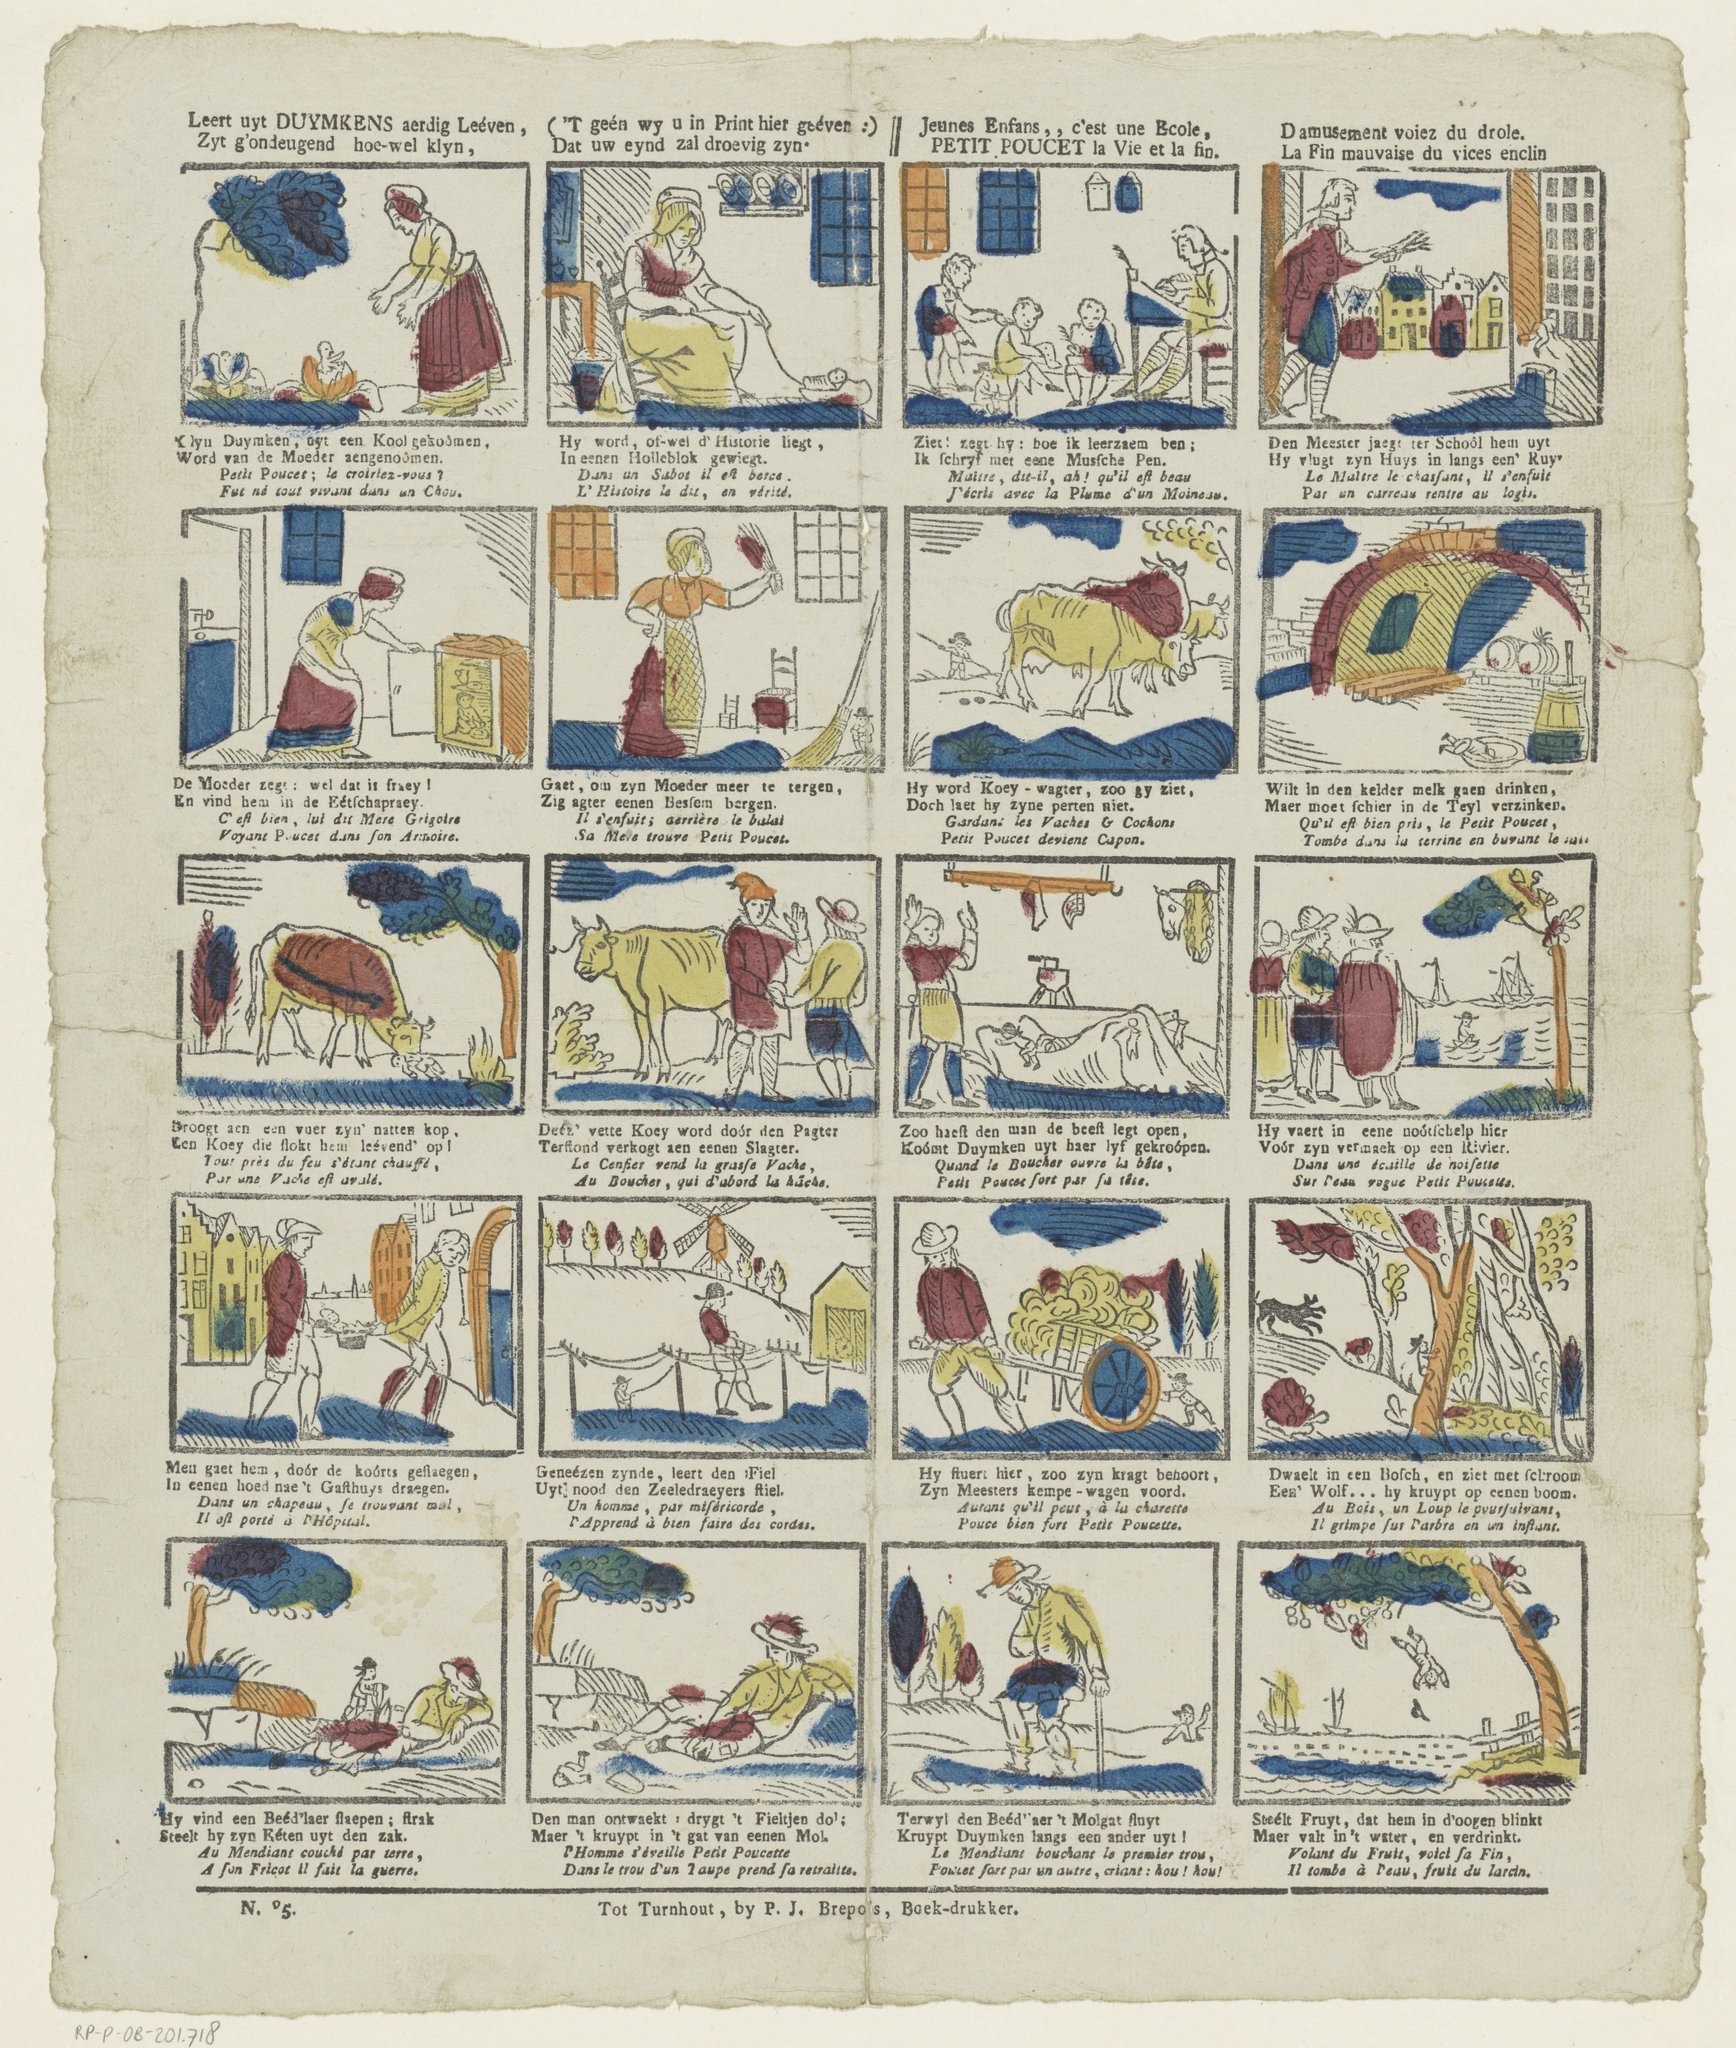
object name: print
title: Leert uyt Duymkens aerdig leéven / ('T geén wy in print hier geéven:) / Zyt g'ondeugend hoe-wel klyn, / Dat uw eynd zal droevig zyn / Jeunes enfans, , c'est une Ecole, / D amusement voiez du drole. / Petit Poucet la vie et la fin. / La fin mauvaise du vices enclin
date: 1800-1833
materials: paper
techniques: colour, letterpress printing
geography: turnhout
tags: tales and fairy tales, tales and fairy tales: little thumbling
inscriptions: collector's mark: Lugt 2760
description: Blad met 2 voorstellingen uit het verhaal van Klein Duimpje. Onder elke voorstelling een tweeregelig vers in het Nederlands en in het Frans. Genummerd linksonder: No. 5.